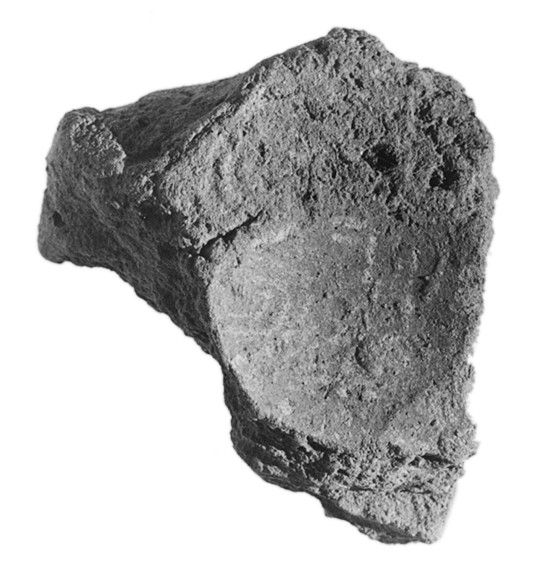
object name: sealing fragment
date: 2030-1640 BCE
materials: clay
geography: egypt